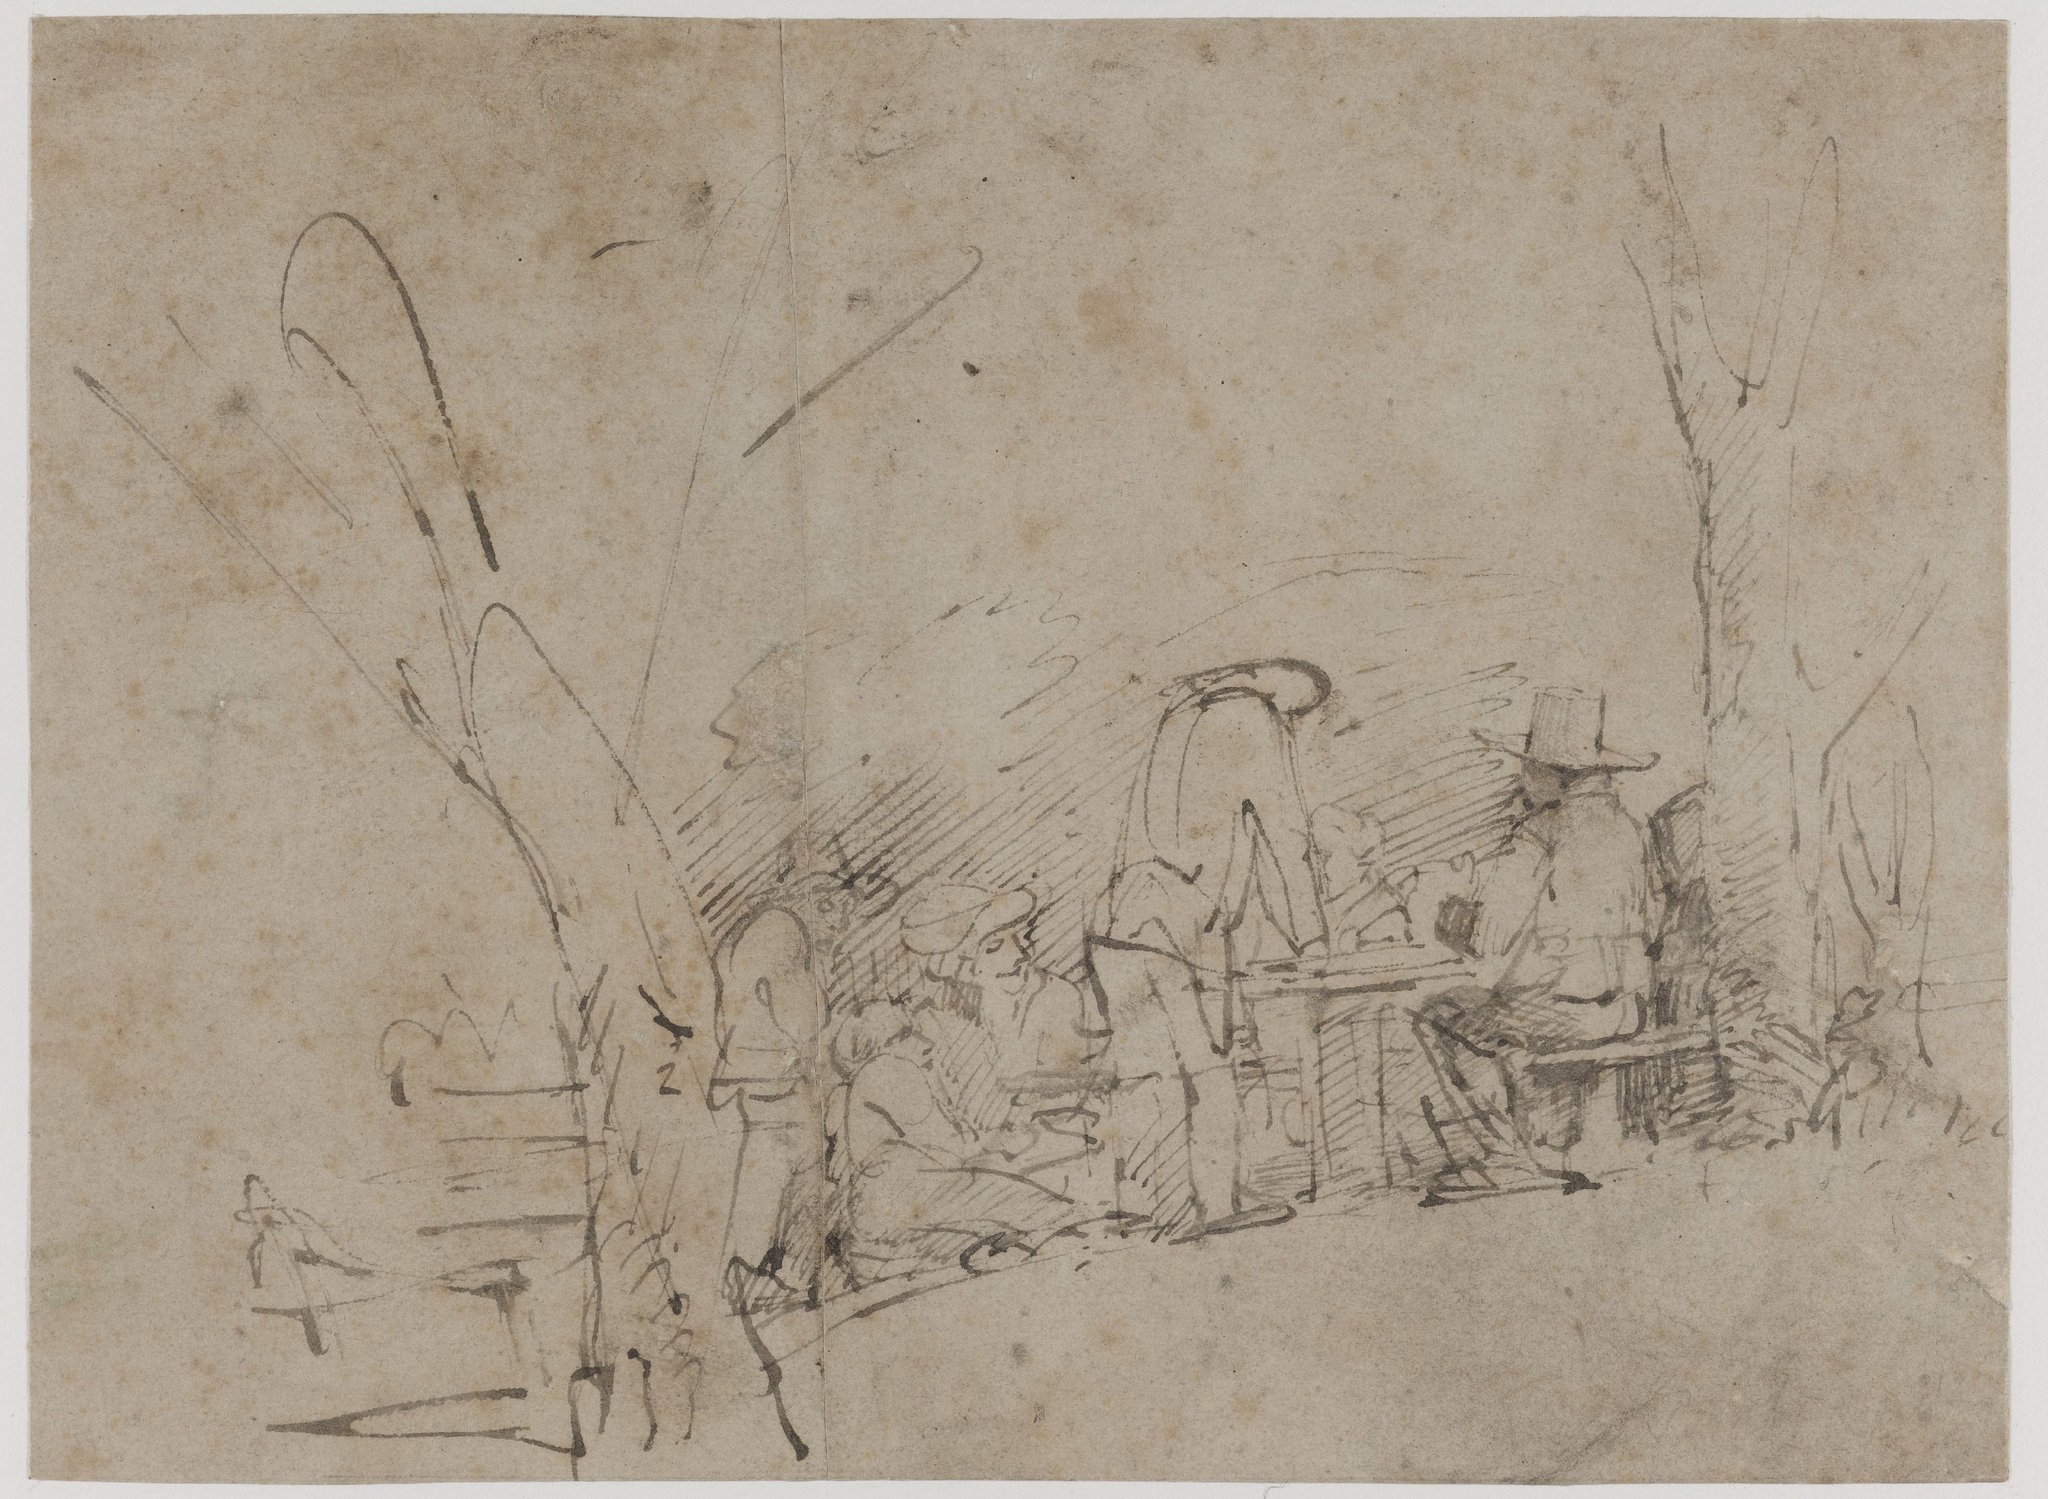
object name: drawing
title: Group of Figures at a Table in the Garden of a Tavern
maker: willem drost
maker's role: draughtsman, painter, print maker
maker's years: 1633-1659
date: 1650-1655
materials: ink, paper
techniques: pen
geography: amsterdam